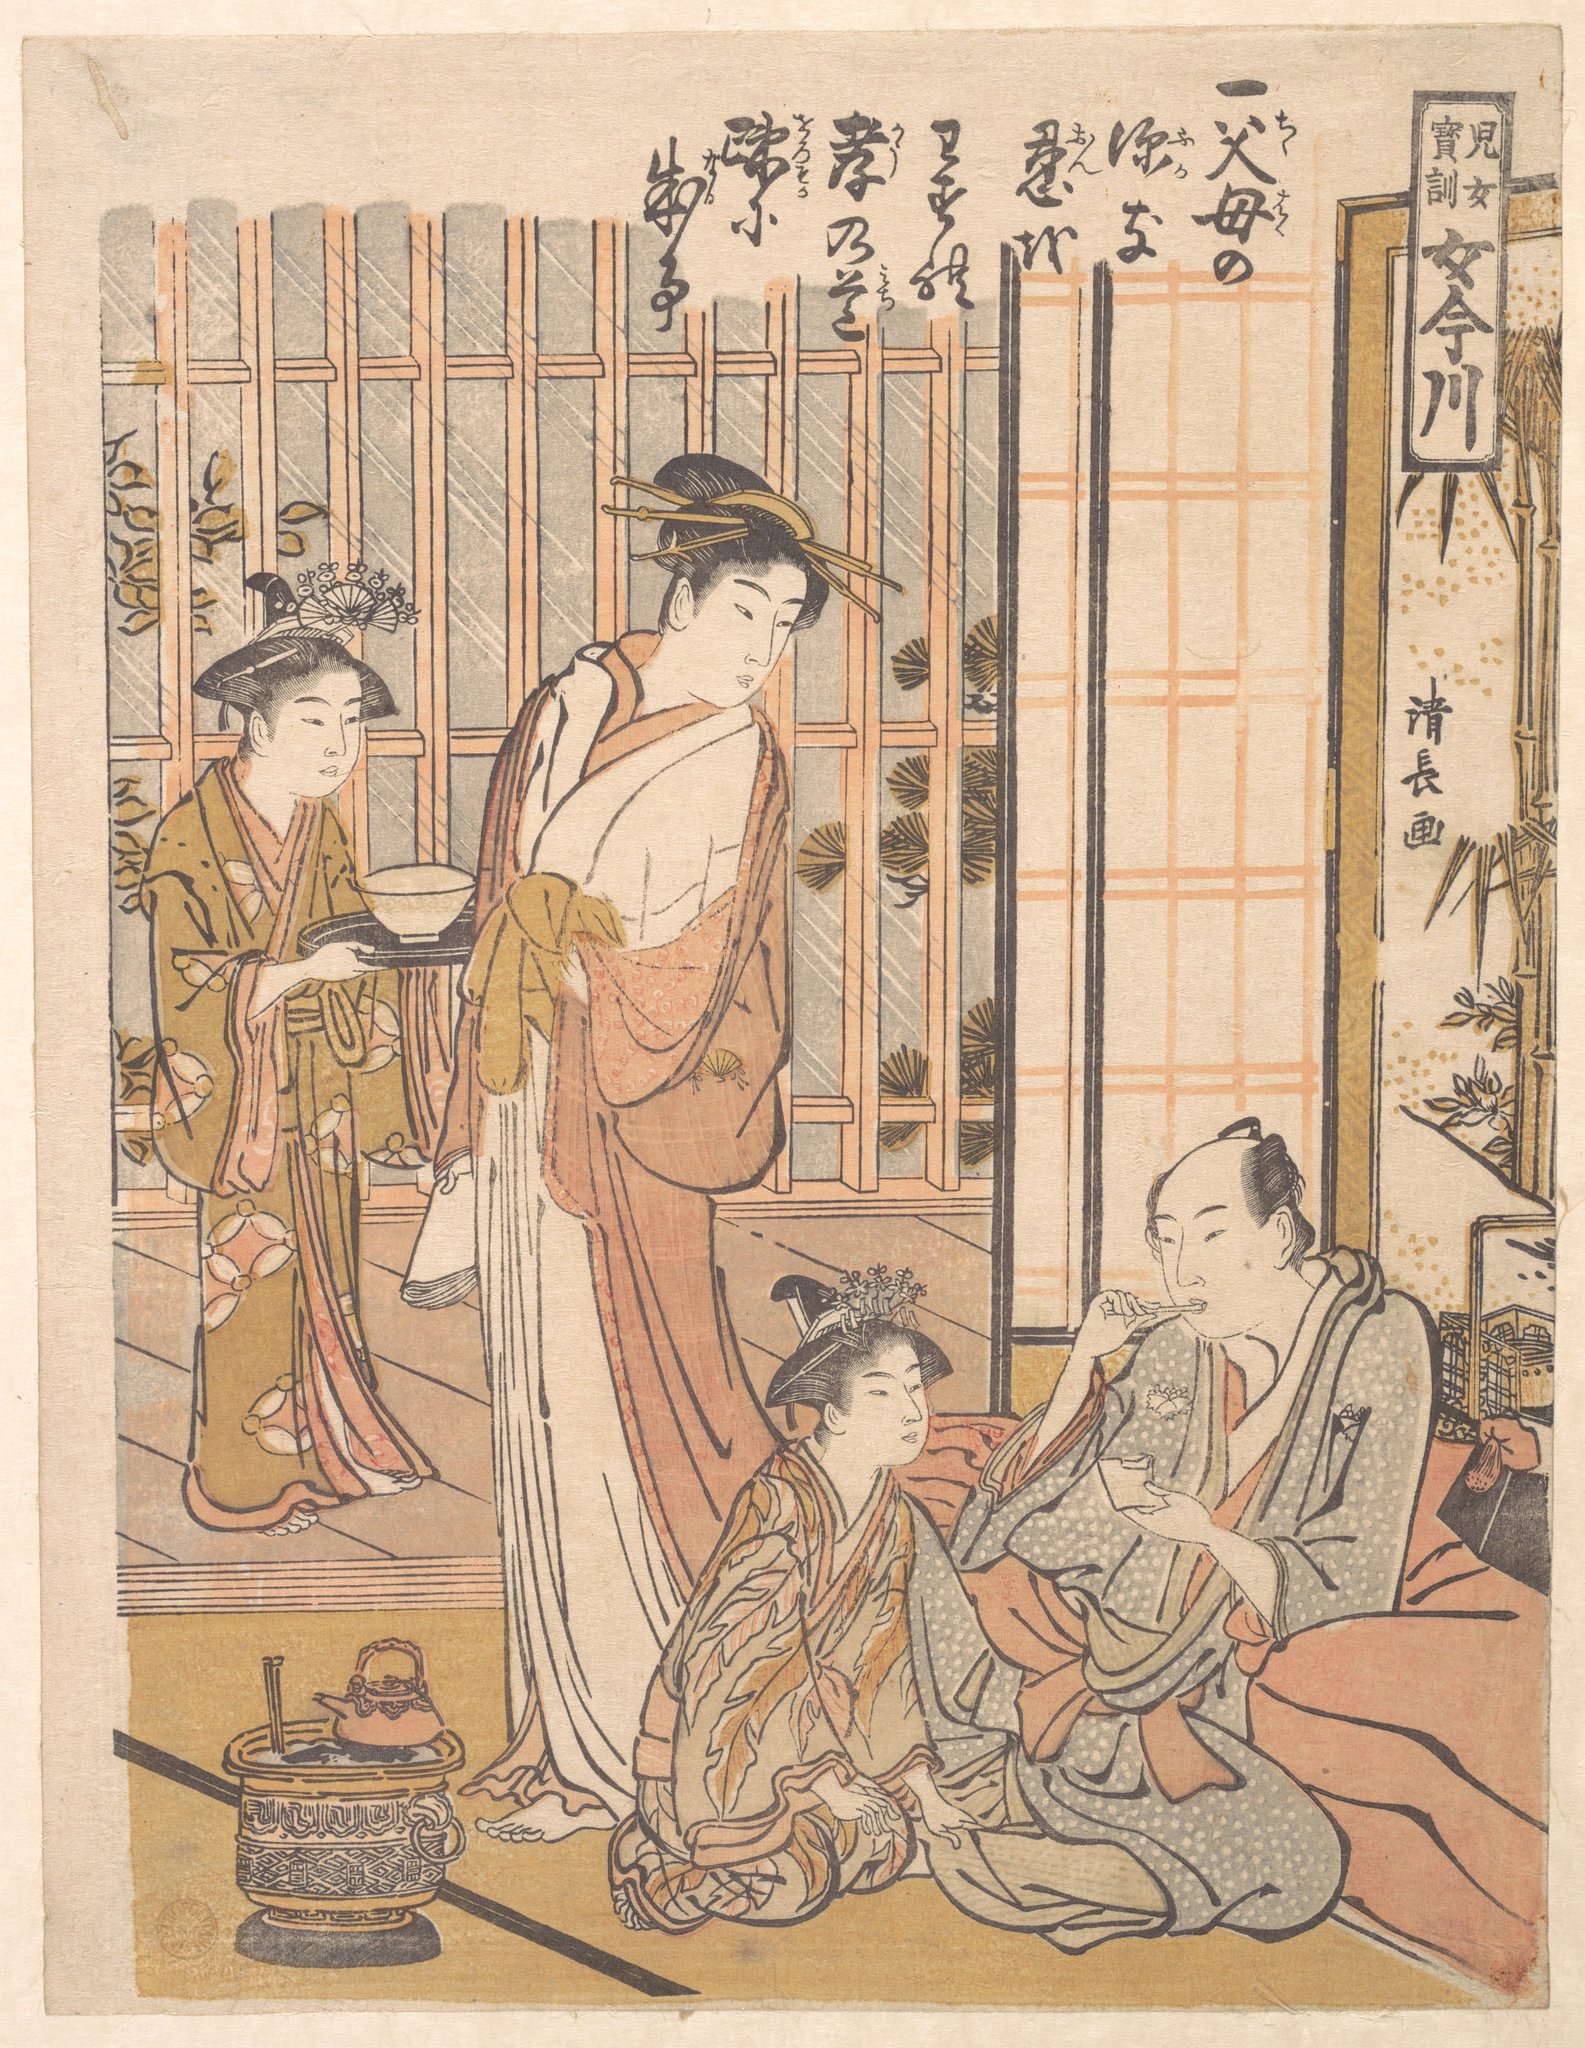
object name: print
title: Forgetting Filial Piety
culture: japanese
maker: torii kiyonaga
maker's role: artist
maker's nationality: japanese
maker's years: 1752-1815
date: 1781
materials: ink, paper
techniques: woodblock print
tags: men,women,servants